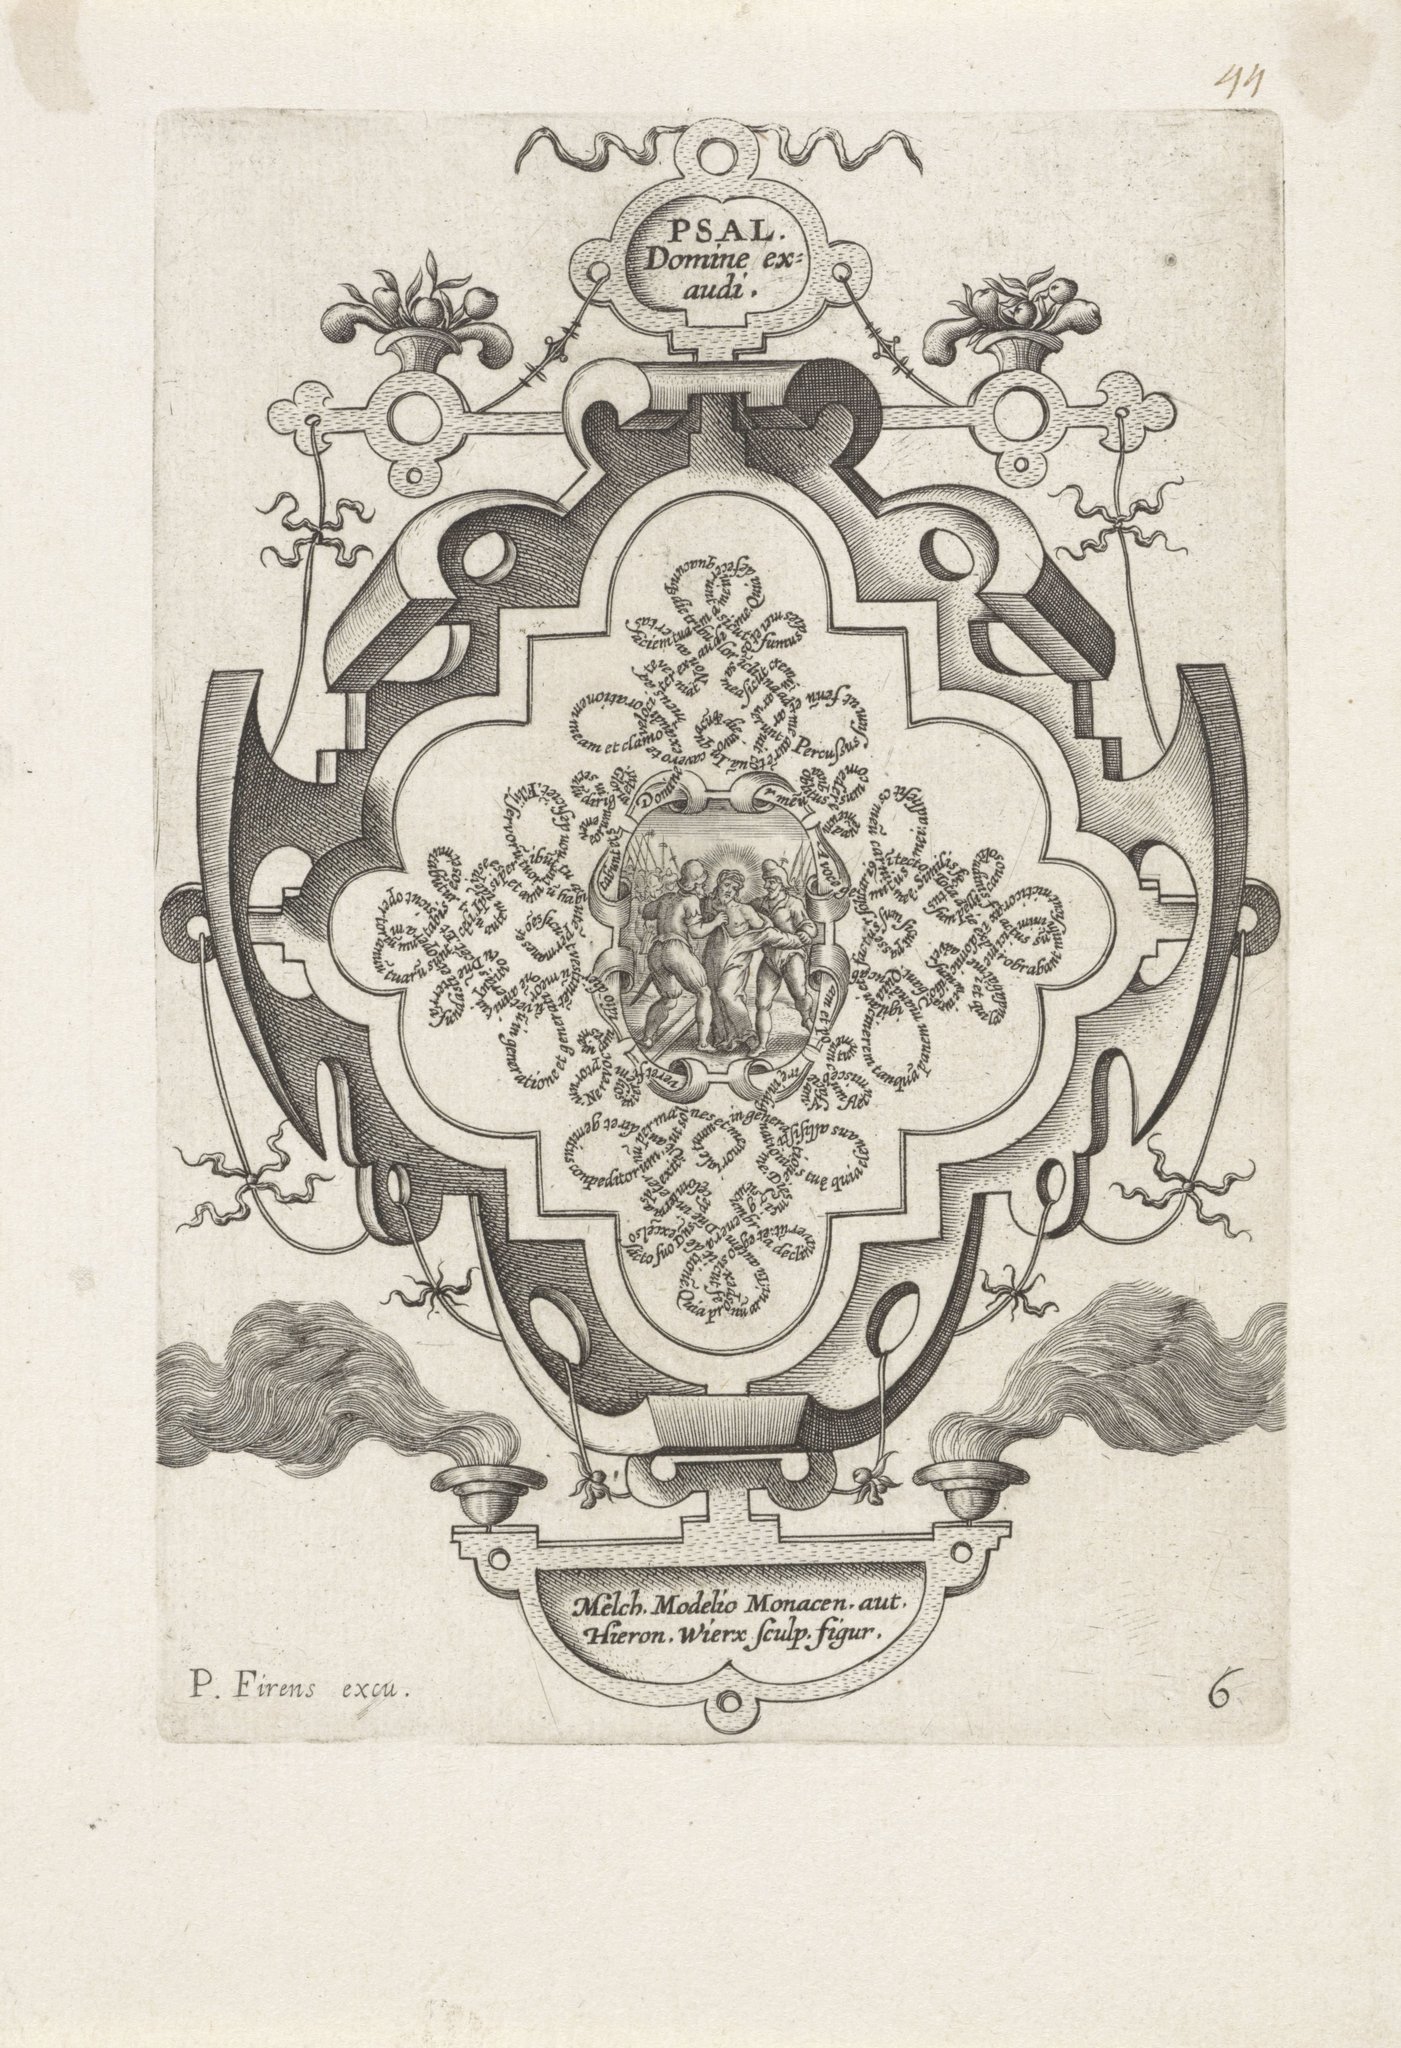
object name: ornament print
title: Septem Psalmi Davidici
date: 1608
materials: paper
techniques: engraving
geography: antwerp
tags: christ disrobed, ornament ~ cartouche, the book of psalms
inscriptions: collector's mark: Lugt 2228, number: ‘44’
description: Twee soldaten rukken de kleren van Christus' lijf. De voorstelling is gevat in een cartouche en geplaatst te midden van de in een knooppatroon gedrukte psalmtekst.